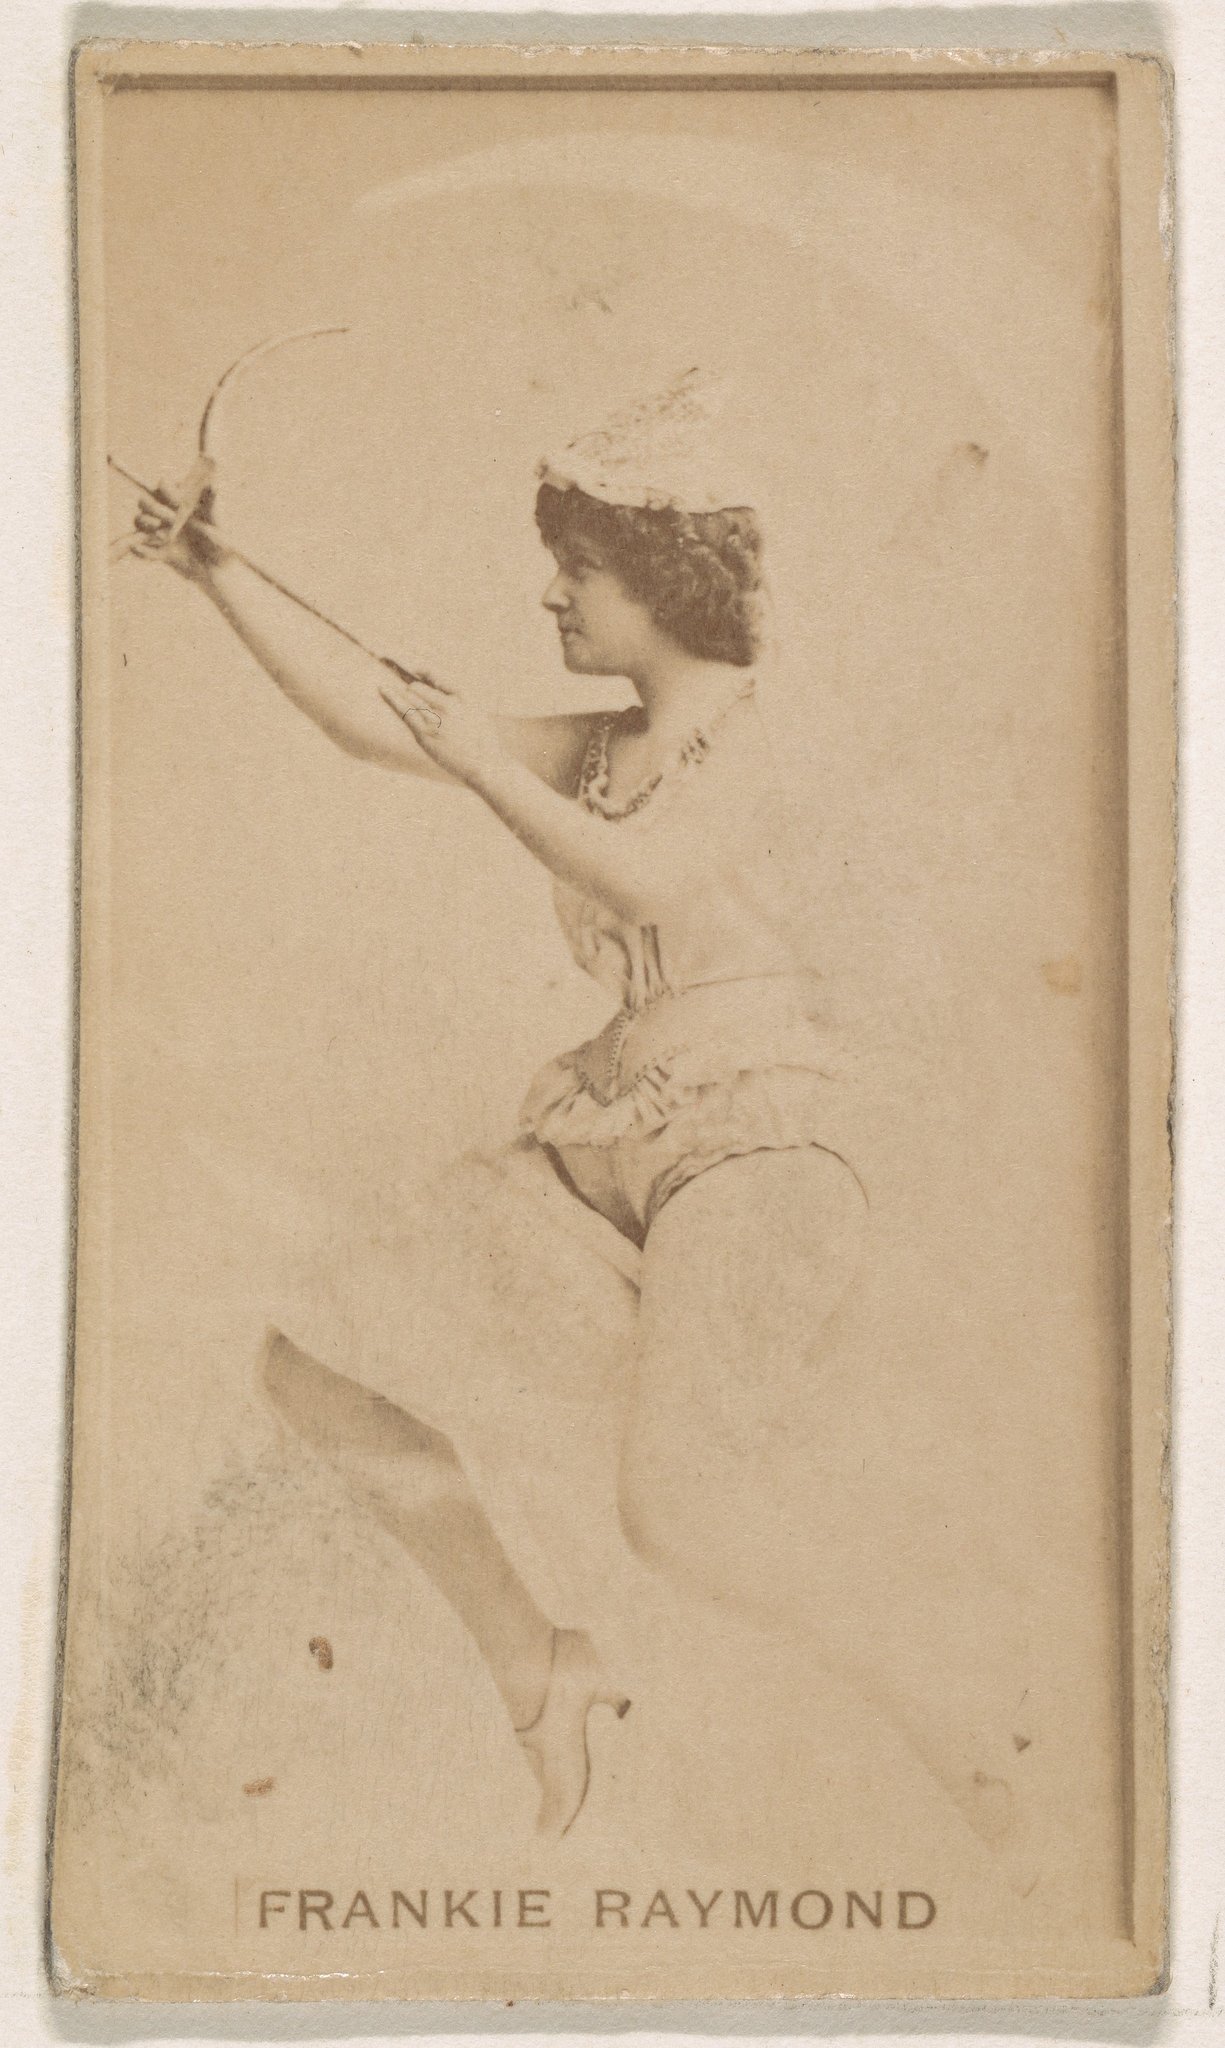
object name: photograph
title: Frankie Raymond, from the Actresses series (N245) issued by Kinney Brothers to promote Sweet Caporal Cigarettes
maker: kinney brothers tobacco company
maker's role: publisher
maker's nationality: american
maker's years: 1869-2011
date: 1890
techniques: albumen silver print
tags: women,actresses